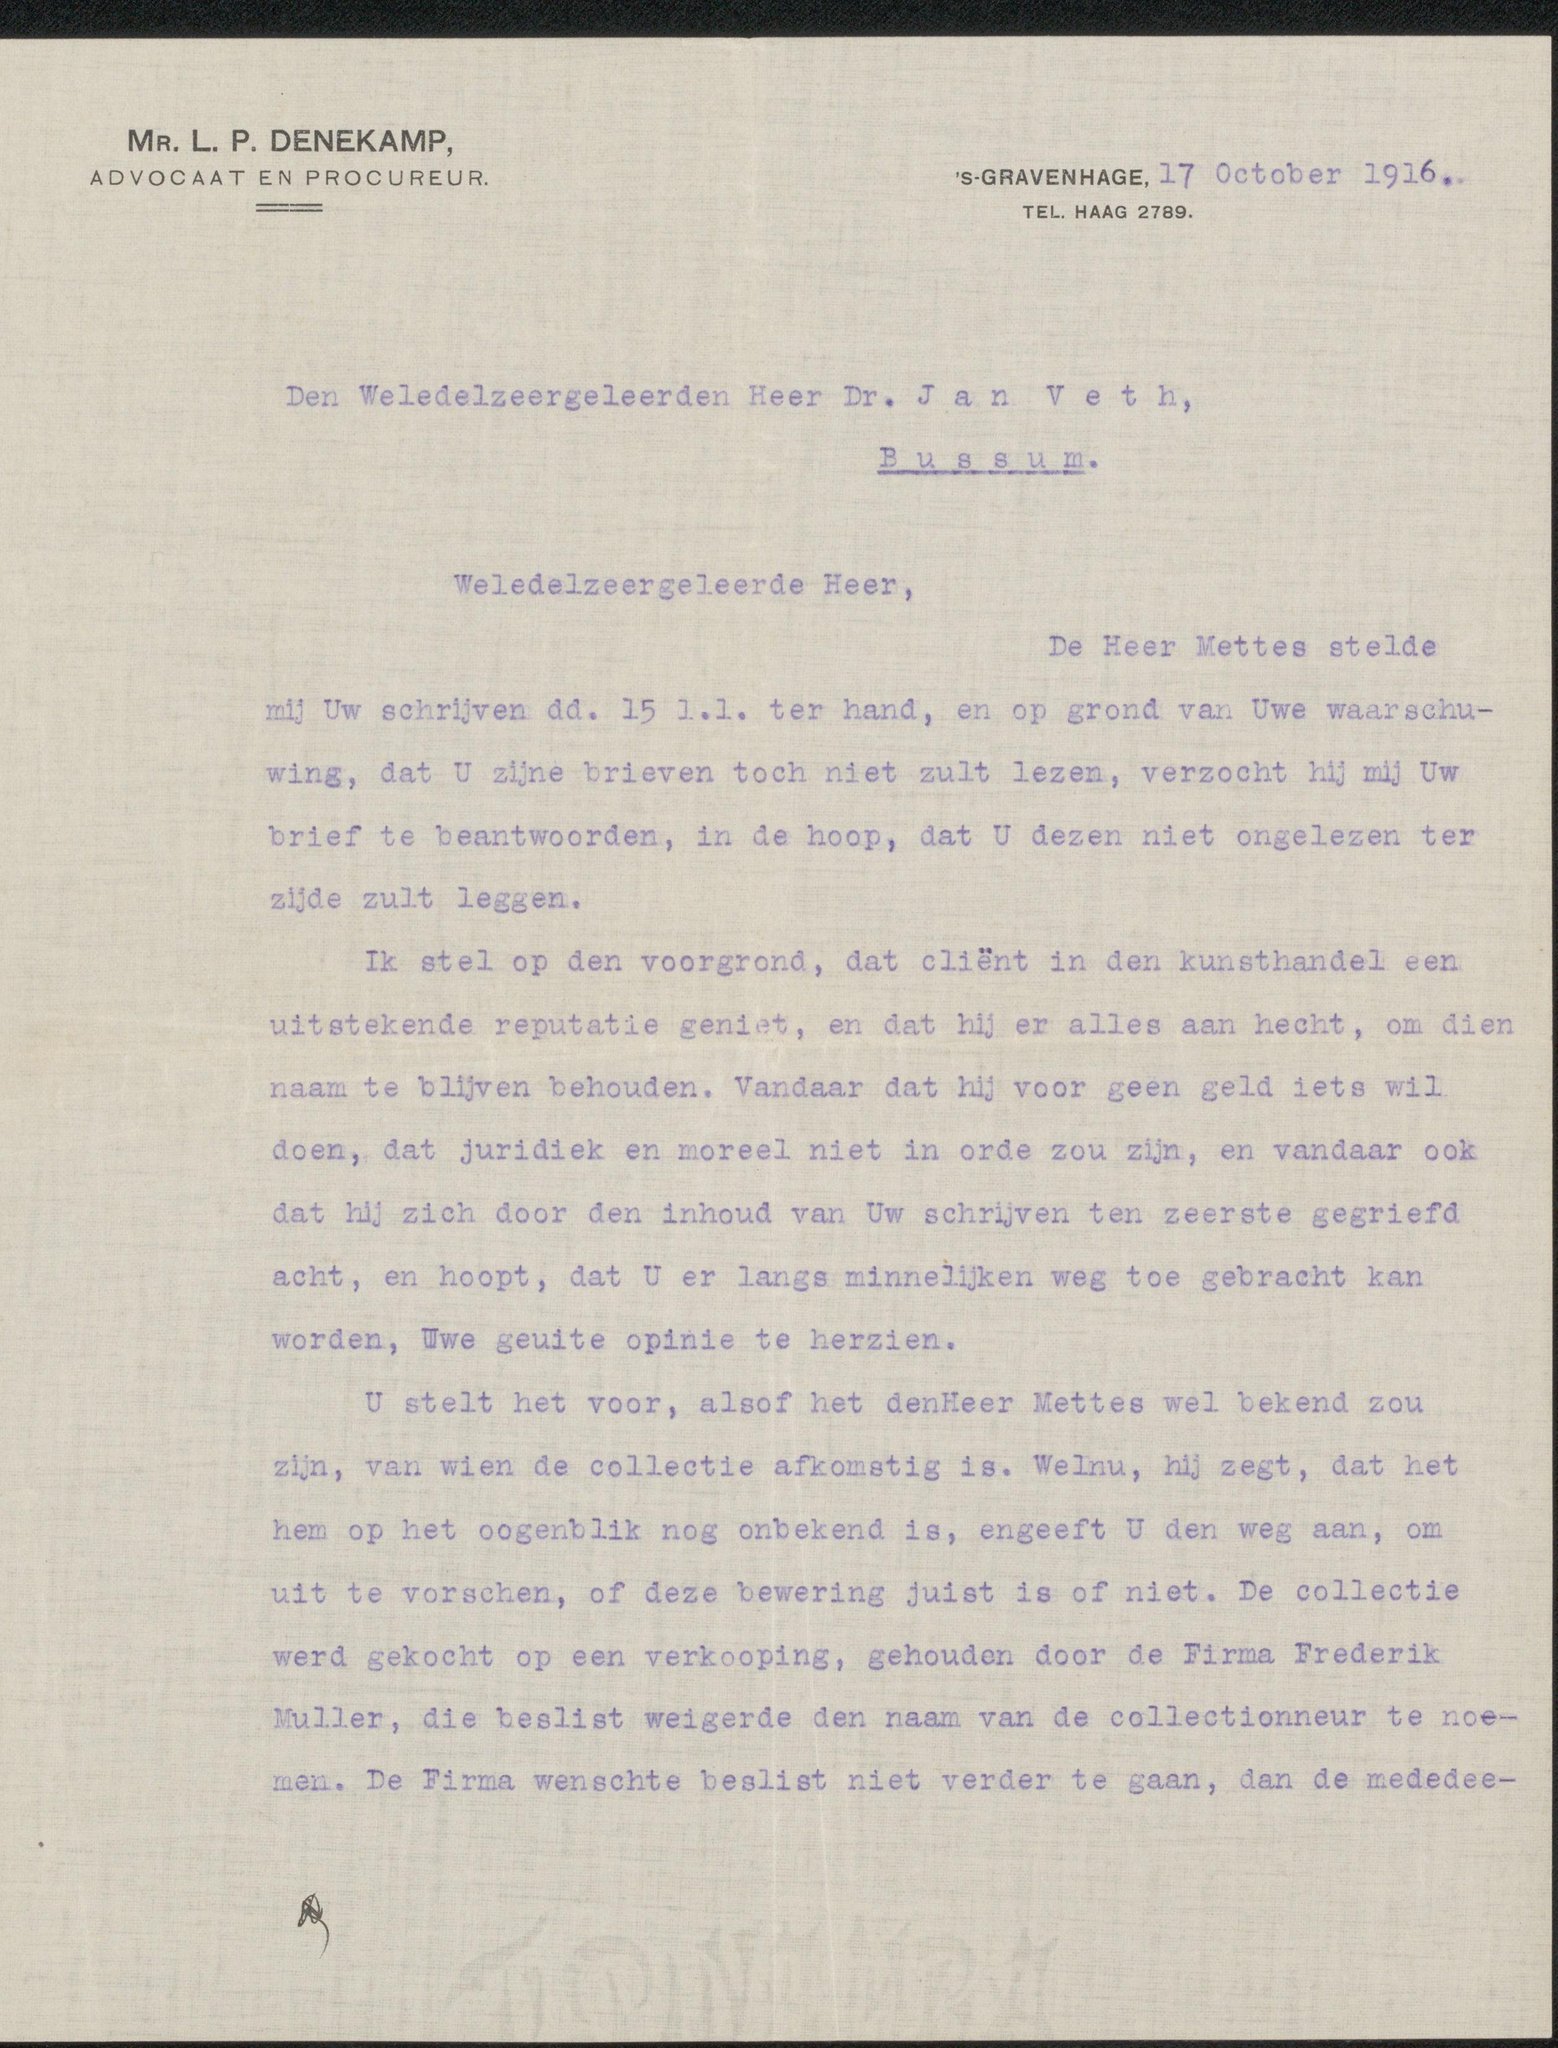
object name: letter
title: Brief aan Jan Veth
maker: l.p. denekamp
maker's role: advocaat, procureur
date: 1916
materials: ink, paper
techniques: pen, printing, typewriting, writing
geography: the hague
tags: dordrecht, designer, jan veth, leiden, amsterdam, painter, print maker, draughtsman, rembrandt van rijn, herman eduard d' audretsch, hoorn (north holland), art trade, art shop, the graphic arts, art collecting, money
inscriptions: collector's mark: ‘RPK’, watermark